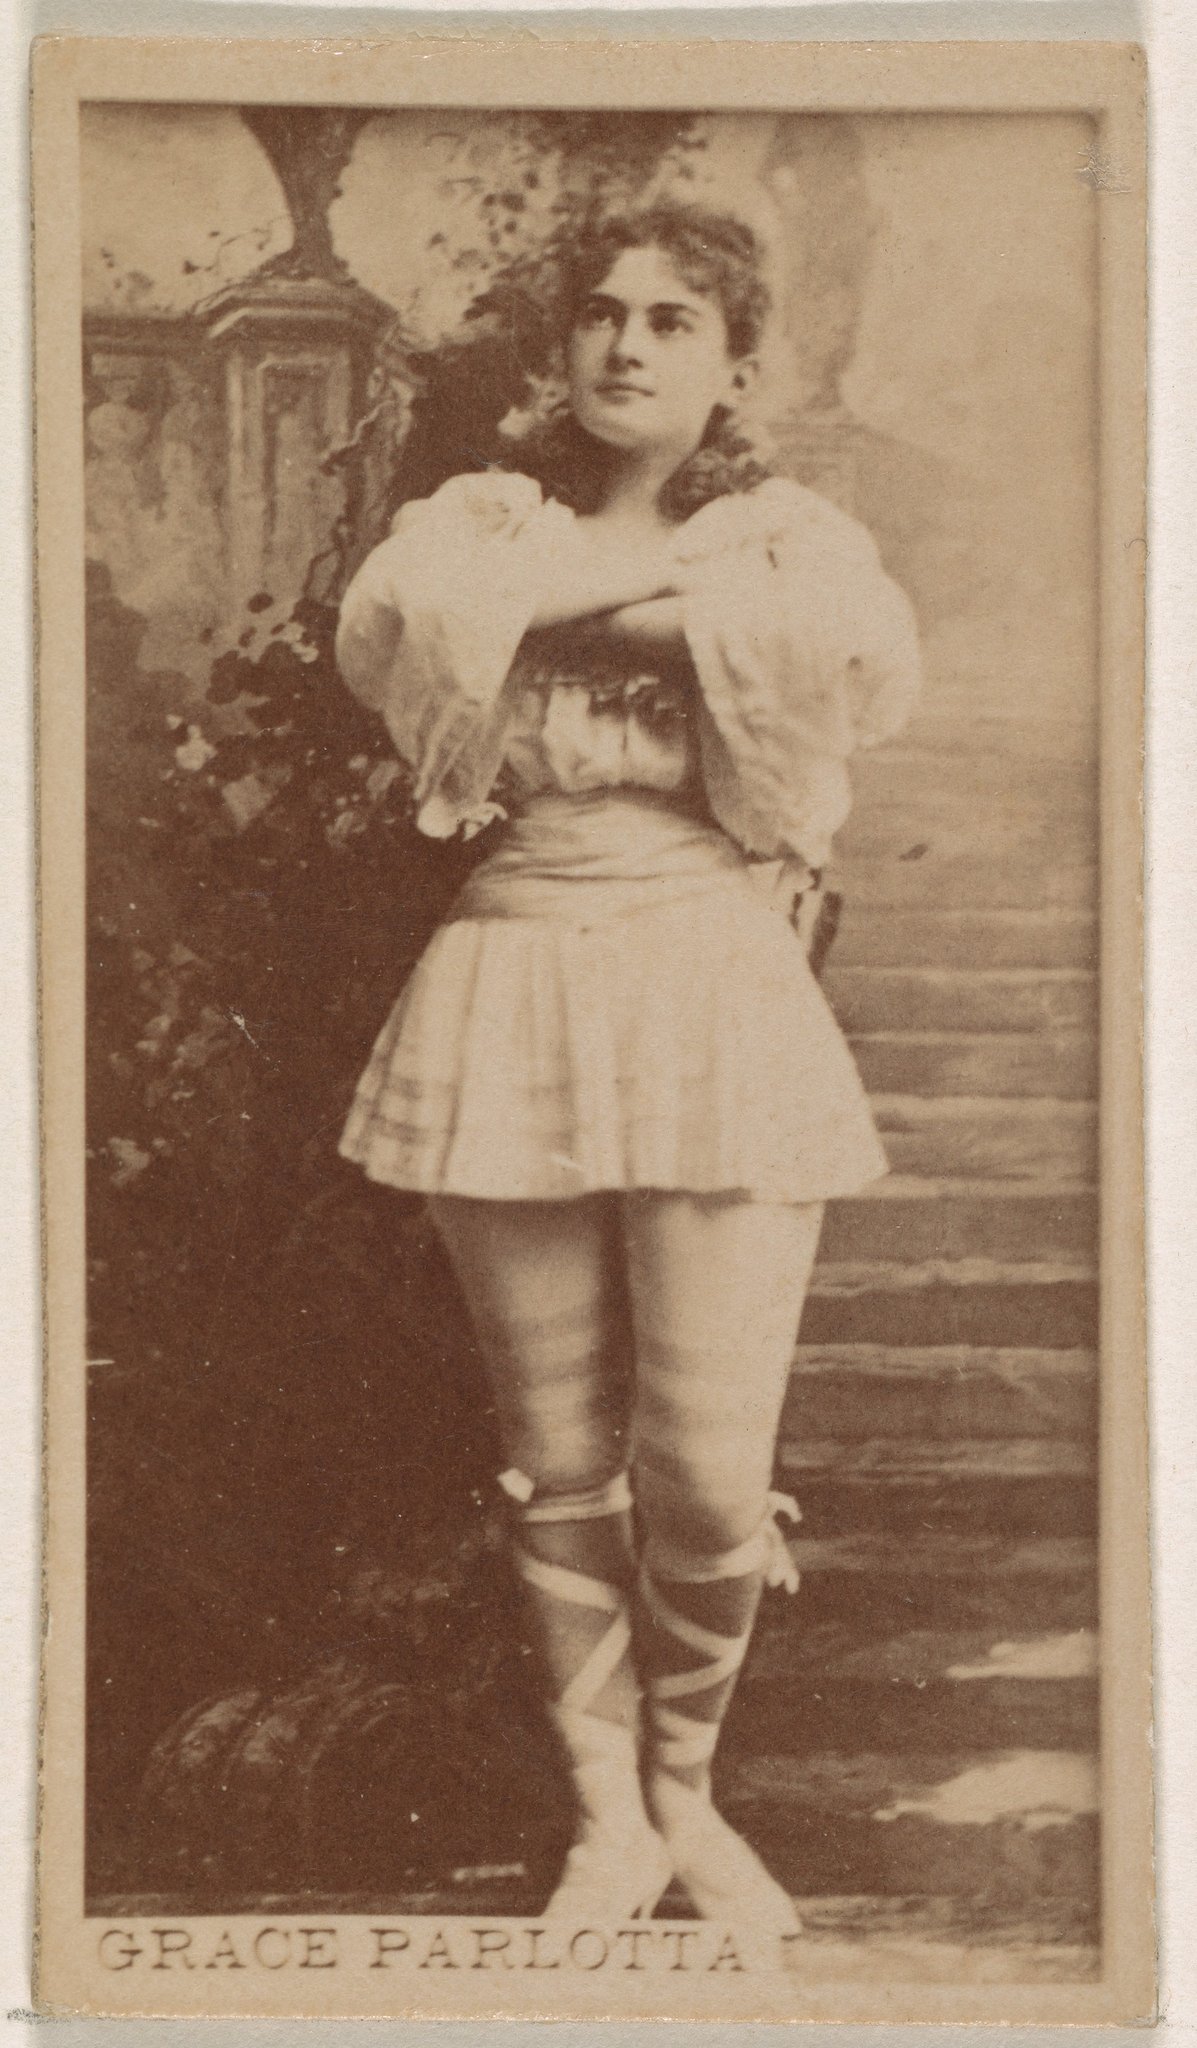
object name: photograph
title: Grace Palotta, from the Actresses series (N245) issued by Kinney Brothers to promote Sweet Caporal Cigarettes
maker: kinney brothers tobacco company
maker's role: publisher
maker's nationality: american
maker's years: 1869-2011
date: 1890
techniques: albumen silver print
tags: portraits,women,actresses